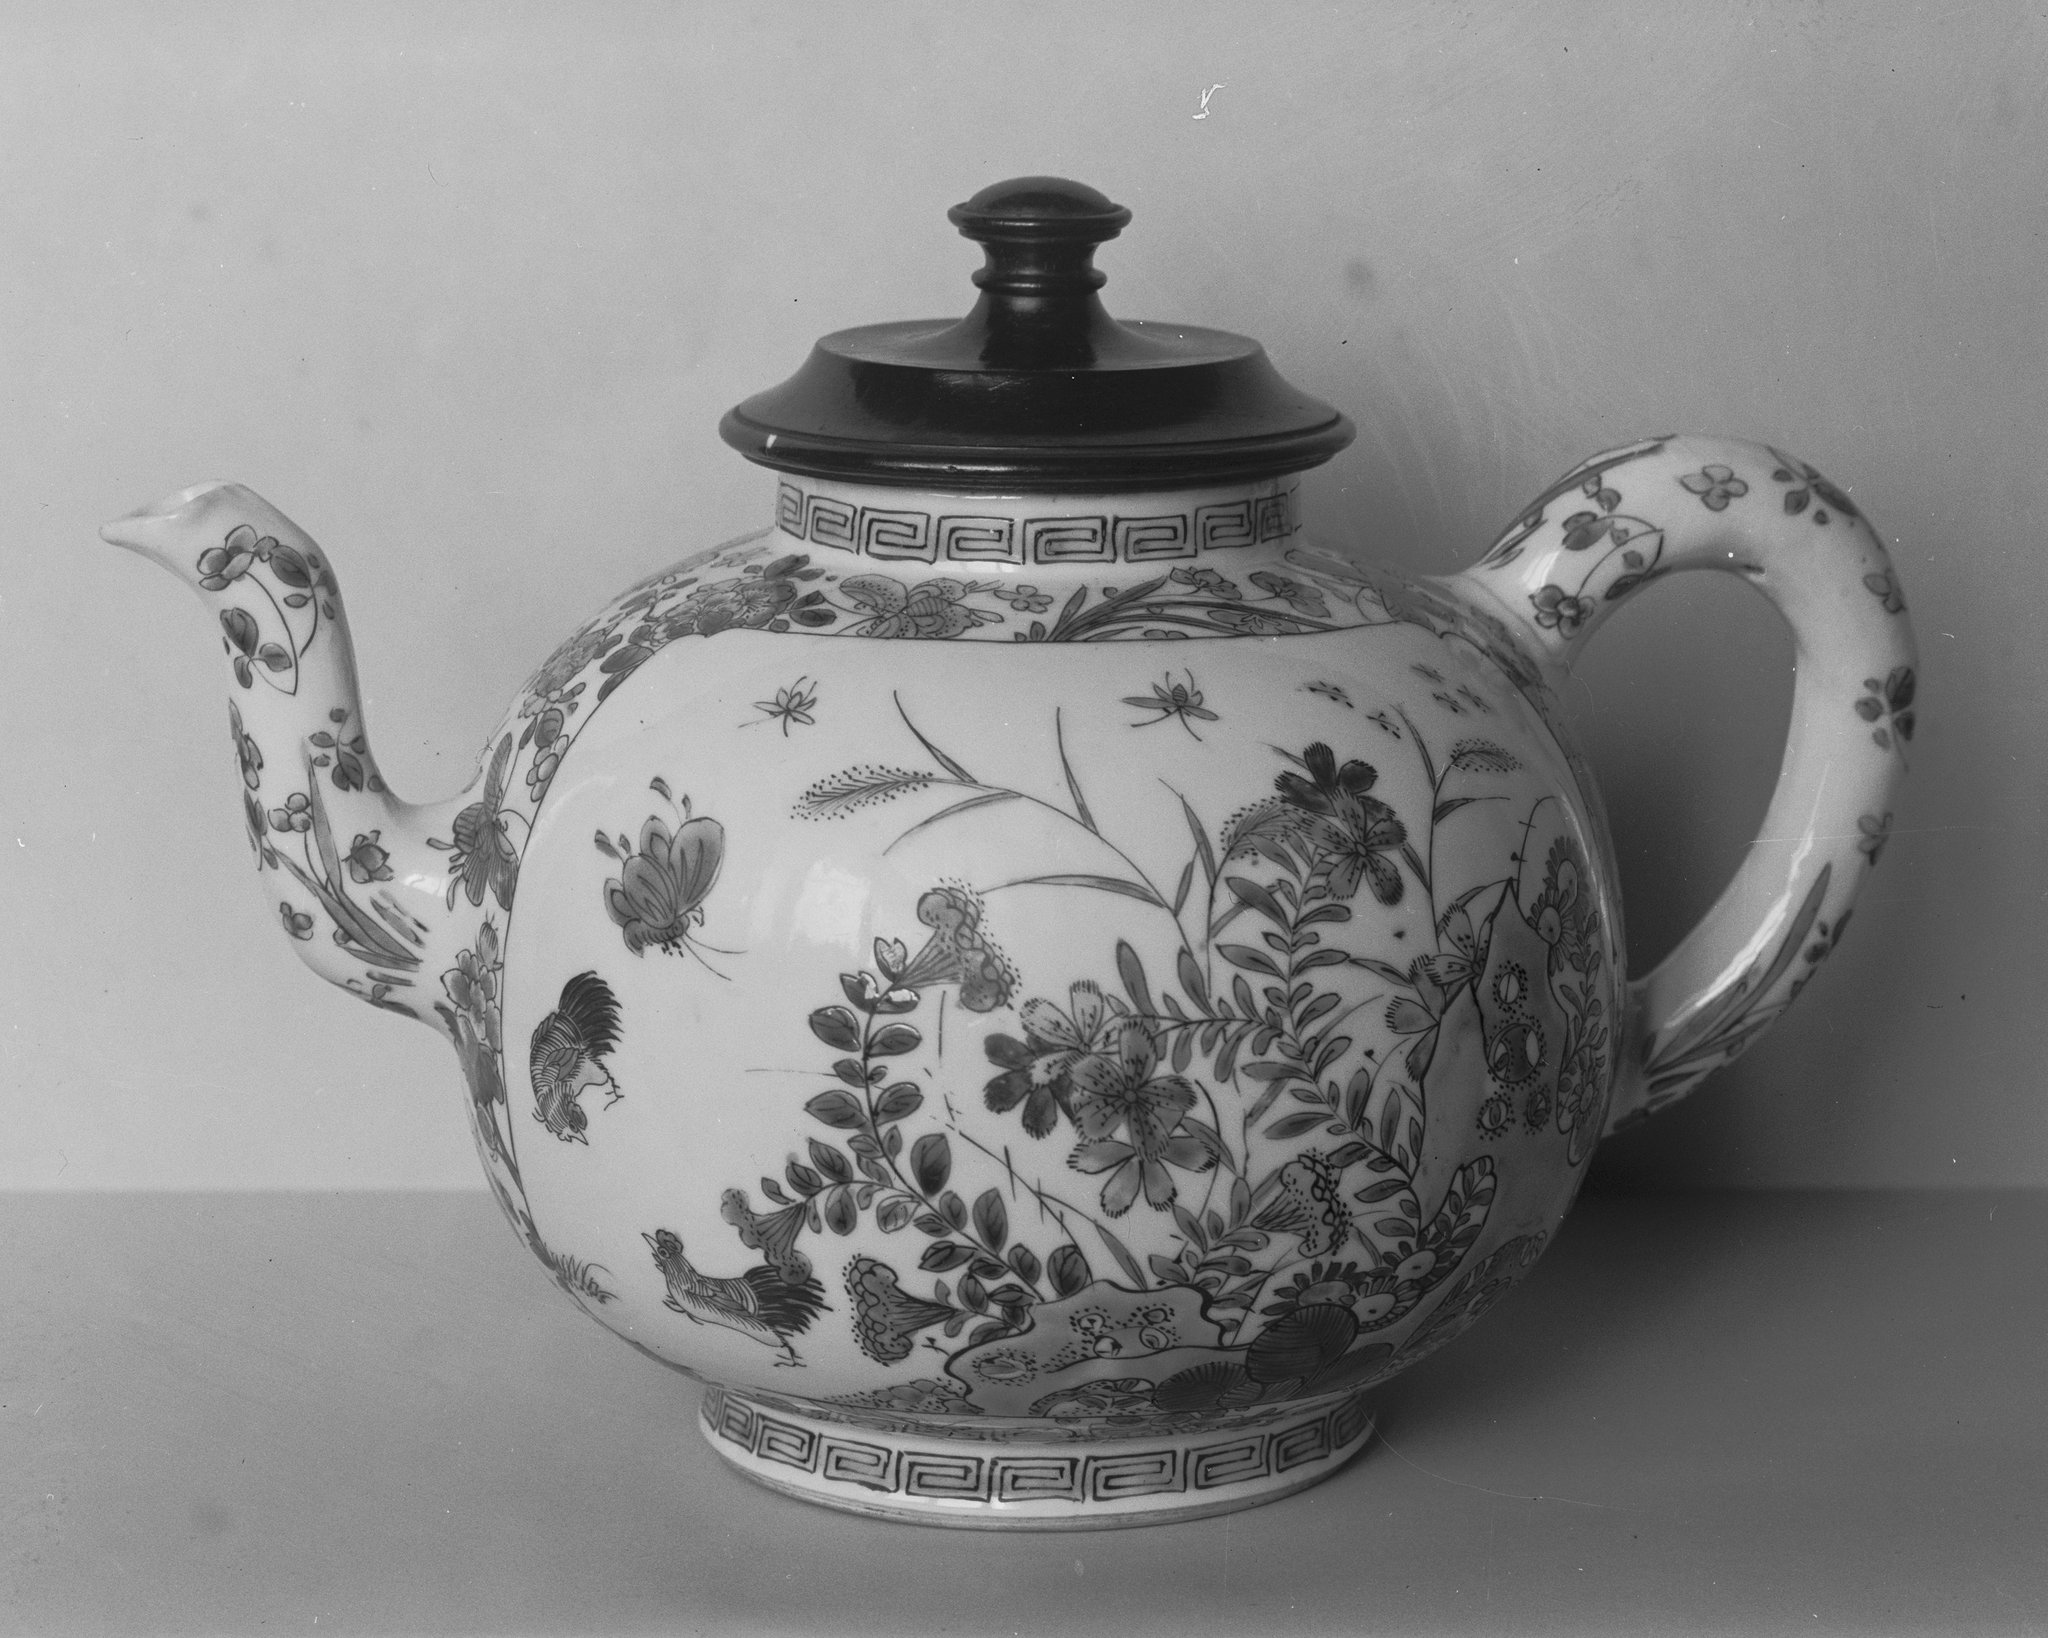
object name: teapot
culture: chinese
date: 1662-1722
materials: porcelain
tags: butterflies